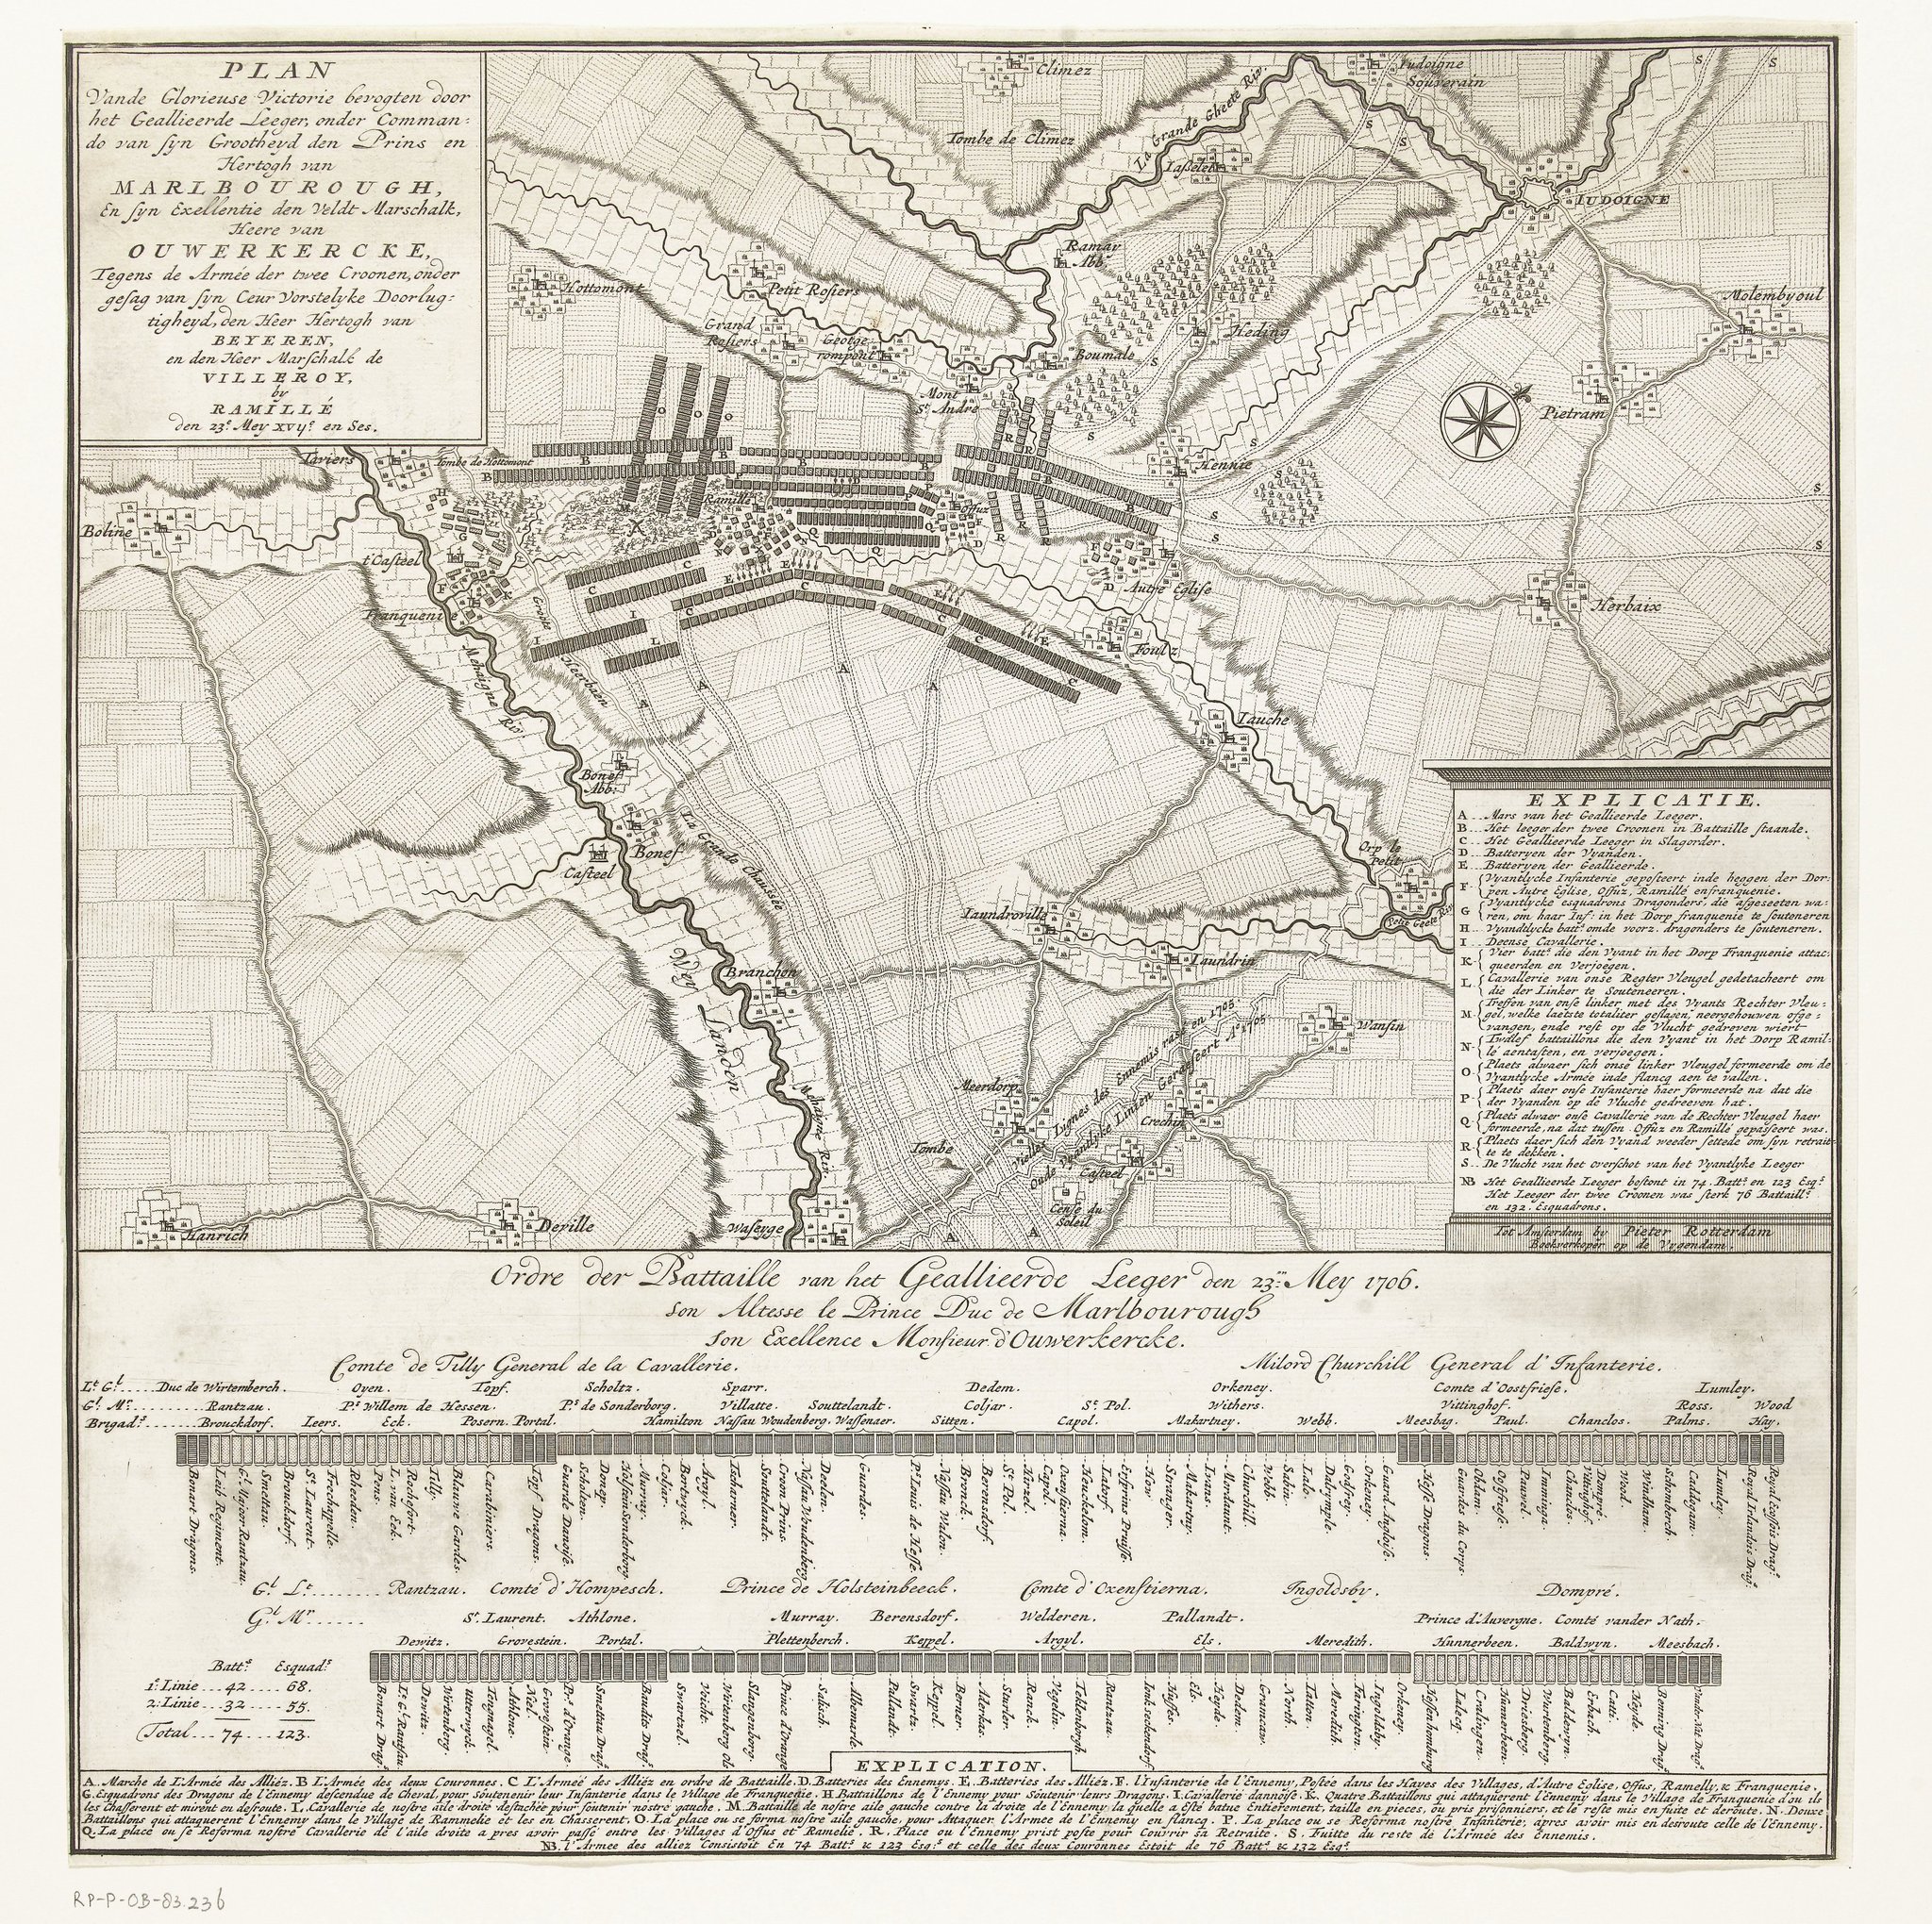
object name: print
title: Plan Van de Glorieuse Victorie bevogten door het Geallieerde Leeger, onder Commando van syn Grootheidden Prins en Hertogh van Marlborough (...) by Ramillé den 23e Mey xvyc. en Ses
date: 1706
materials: paper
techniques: etching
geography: amsterdam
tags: lyon, paris, françois de neufville (hertog van villeroy), maximiliaan ii emanuel (keurvorst van beieren), john churchill (1e hertog van marlborough), the hague, maps of separate countries or regions, battle (+ land forces)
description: Kaart van de slag bij Ramillies tussen de Geallieerden onder de hertog van Marlborough en de Heer van Ouwerkerk en de Fransen en Spanjaarden onder de keurvorst van Beieren en de hertog van Villeroy, 23 mei 1706. Onder het plan de slagorde van de Geallieerde troepen.